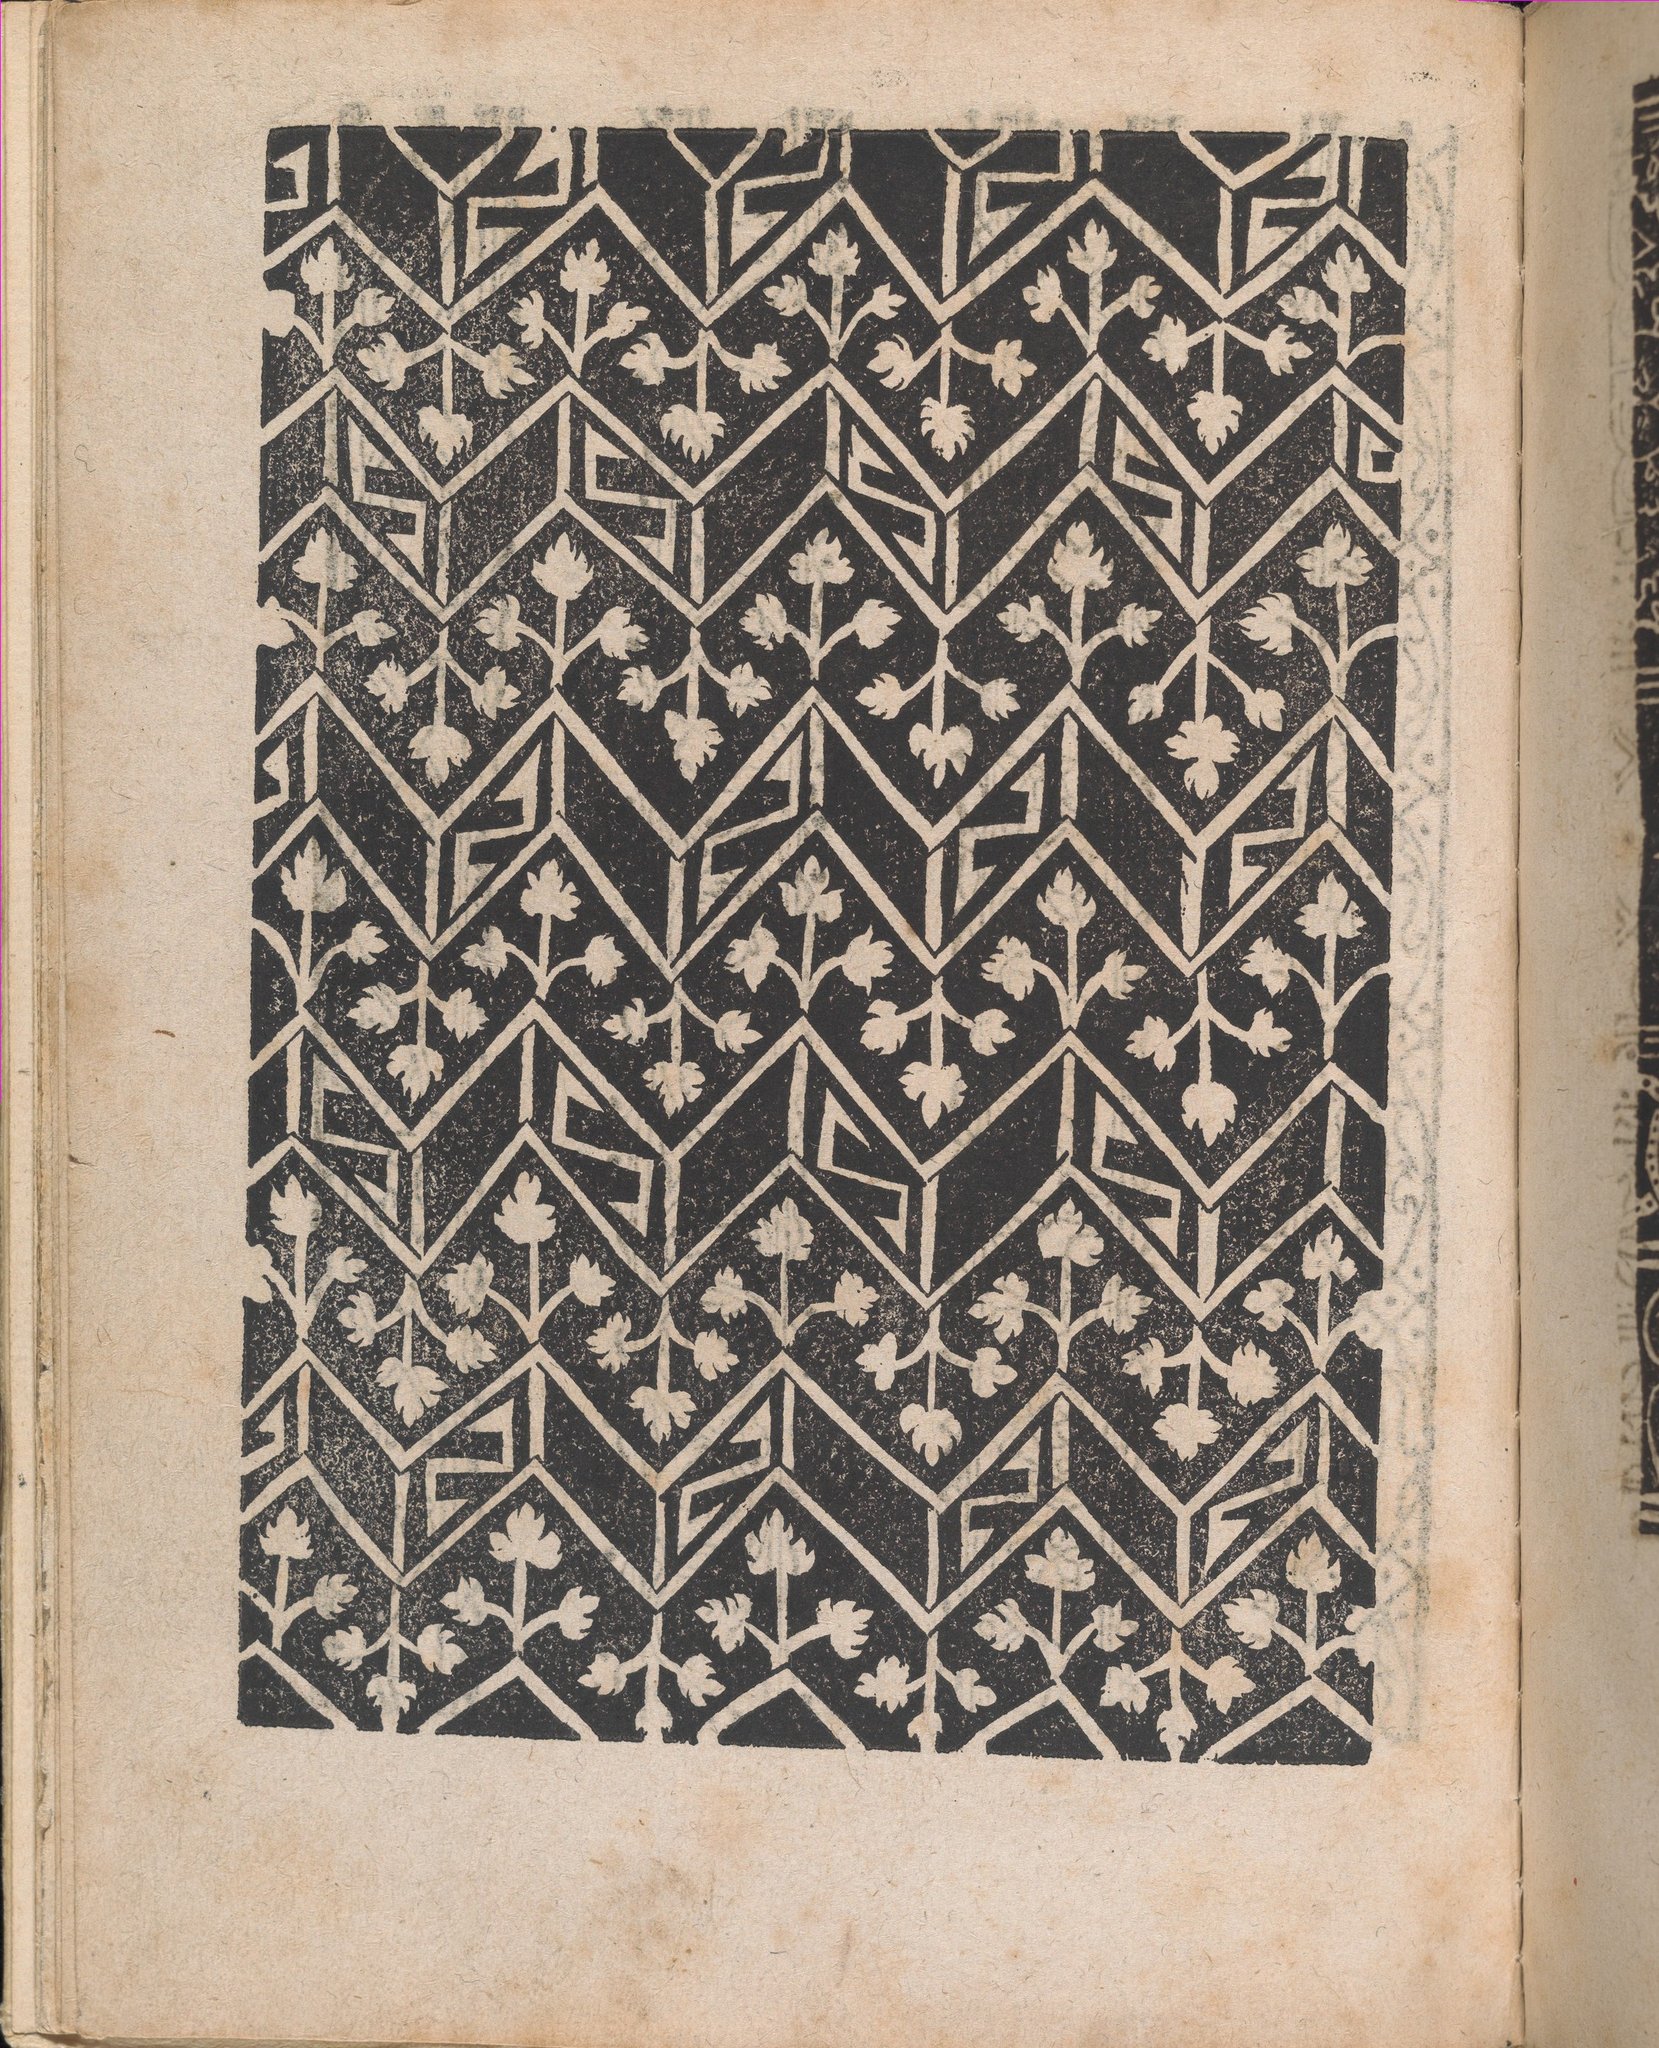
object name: book print ornament architecture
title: Modelbuch aller Art Nehens vn Stickens (Page 8v)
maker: christian egenolff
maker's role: publisher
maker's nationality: german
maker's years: 1502-1555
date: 1535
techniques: woodcut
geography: germany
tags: ornament